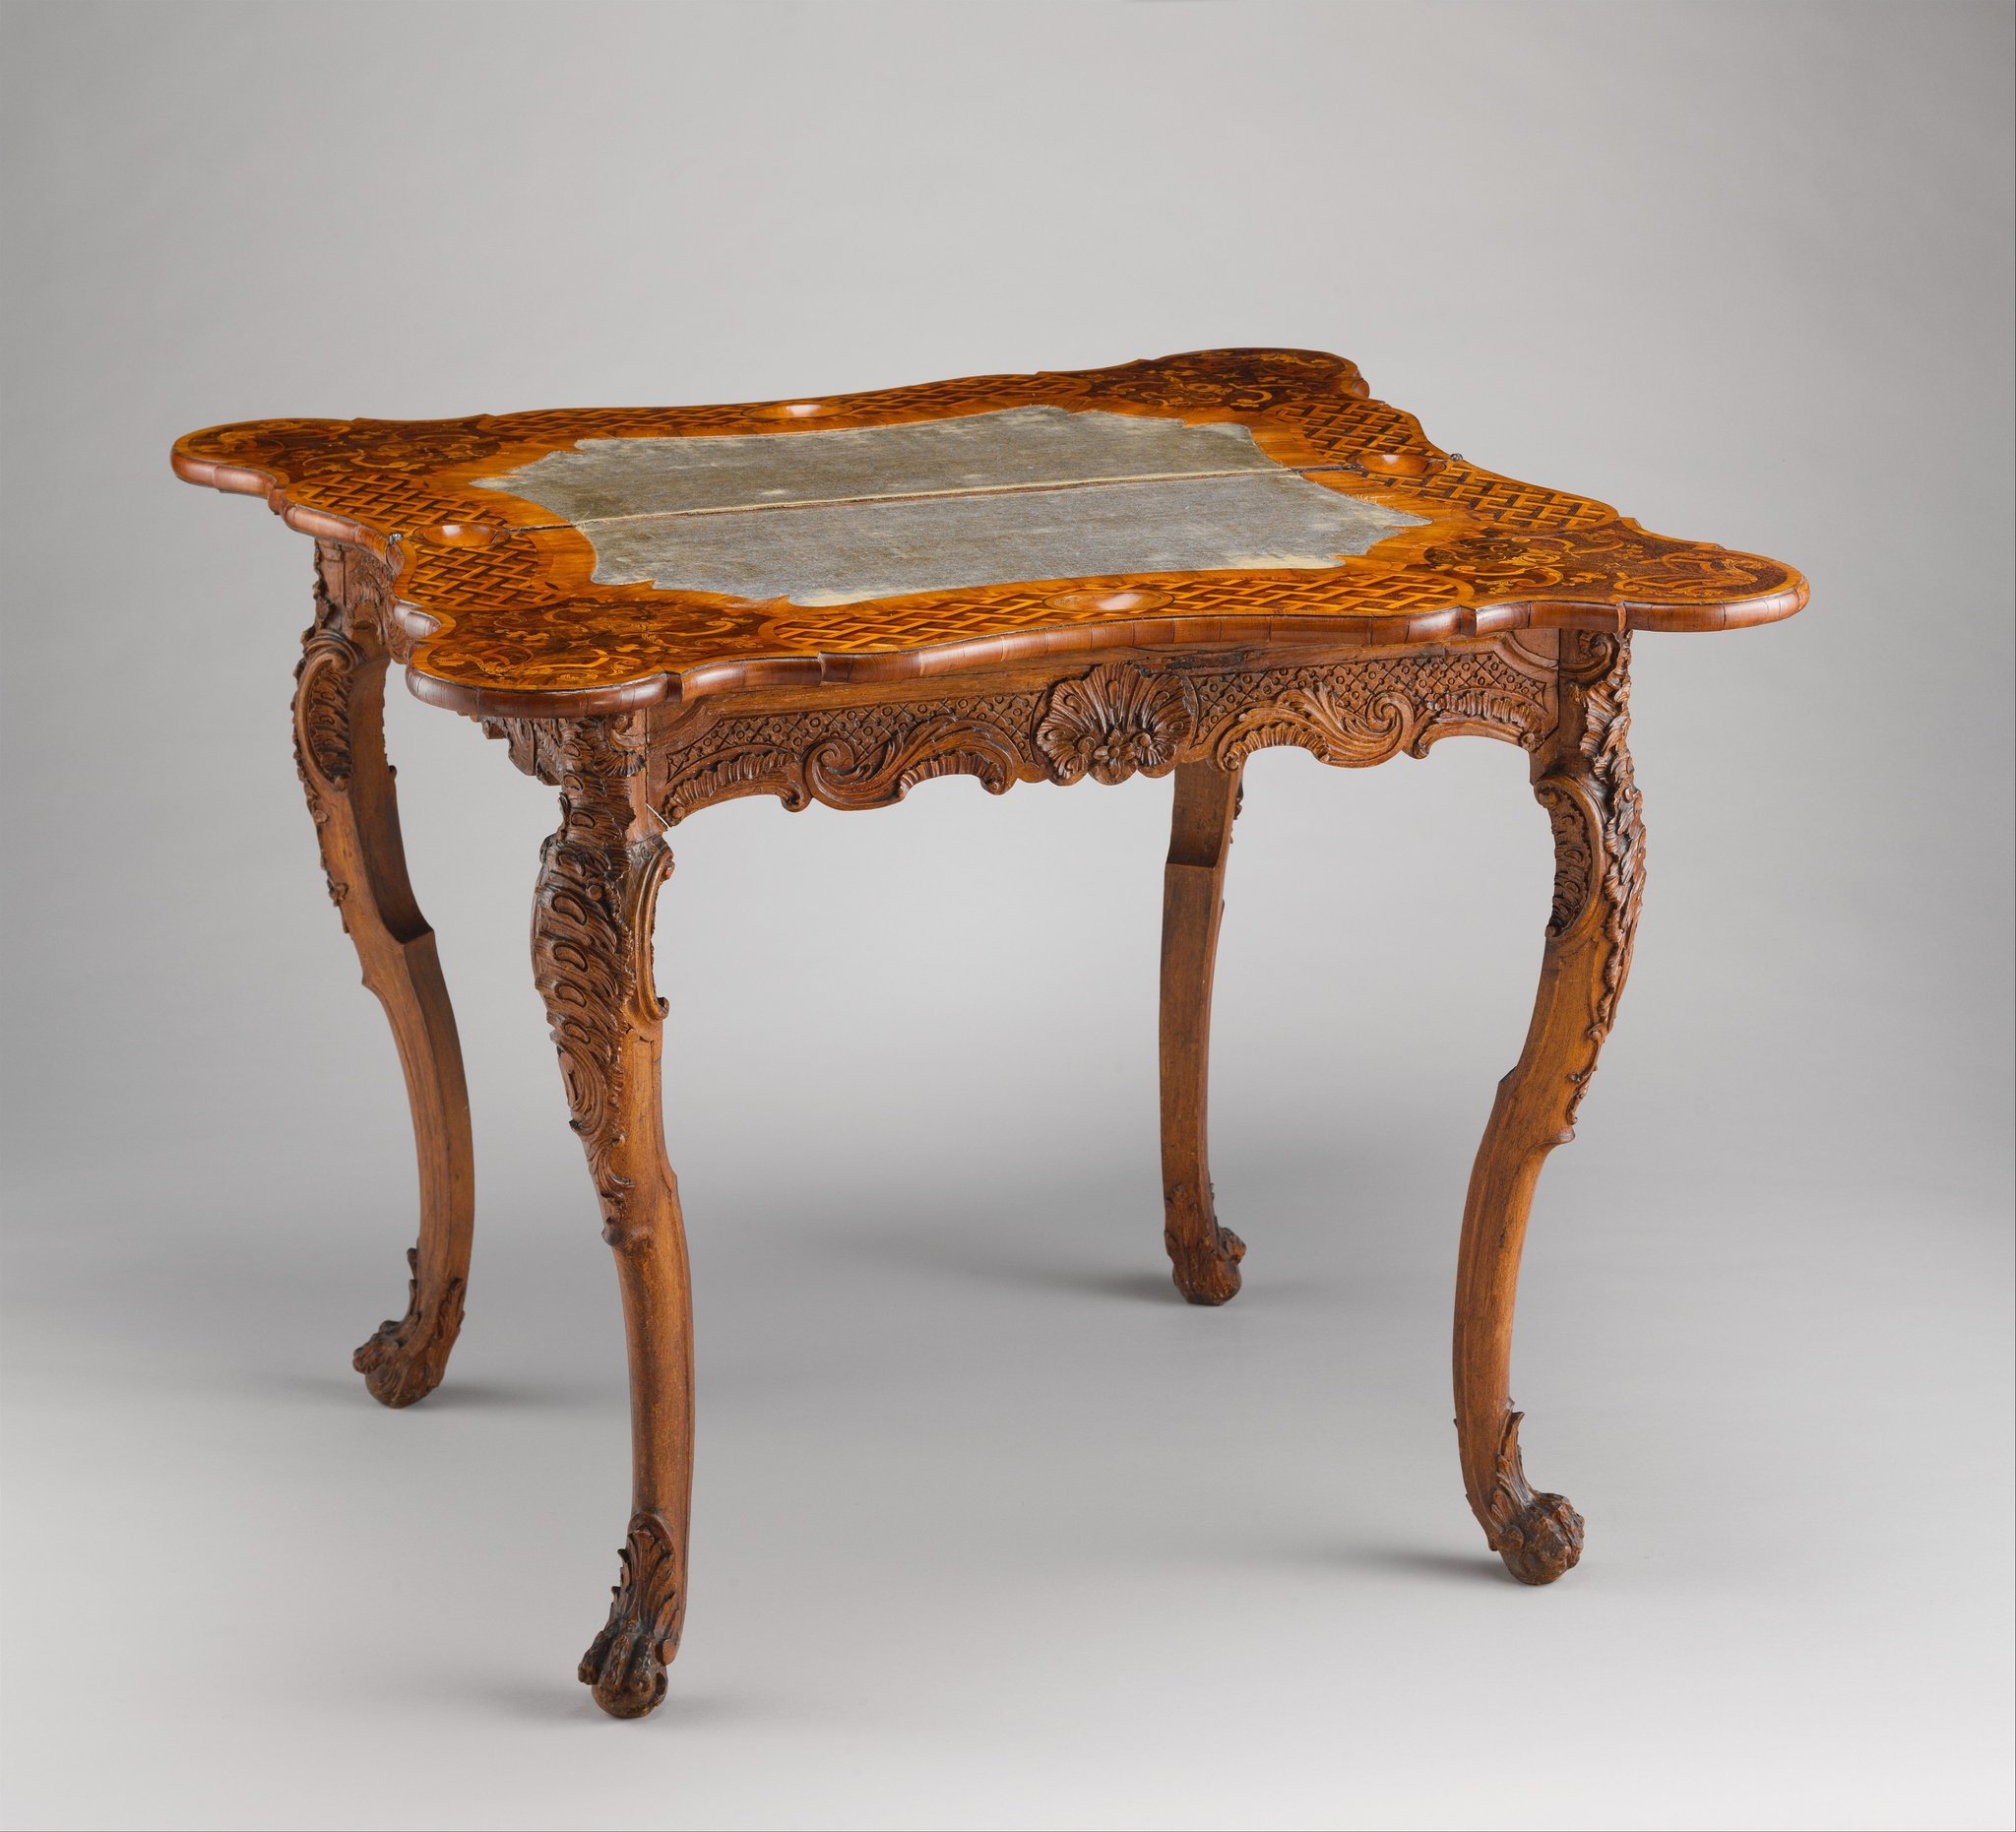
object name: card table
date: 1745-1750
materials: wood, iron, velvet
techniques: carving, stain